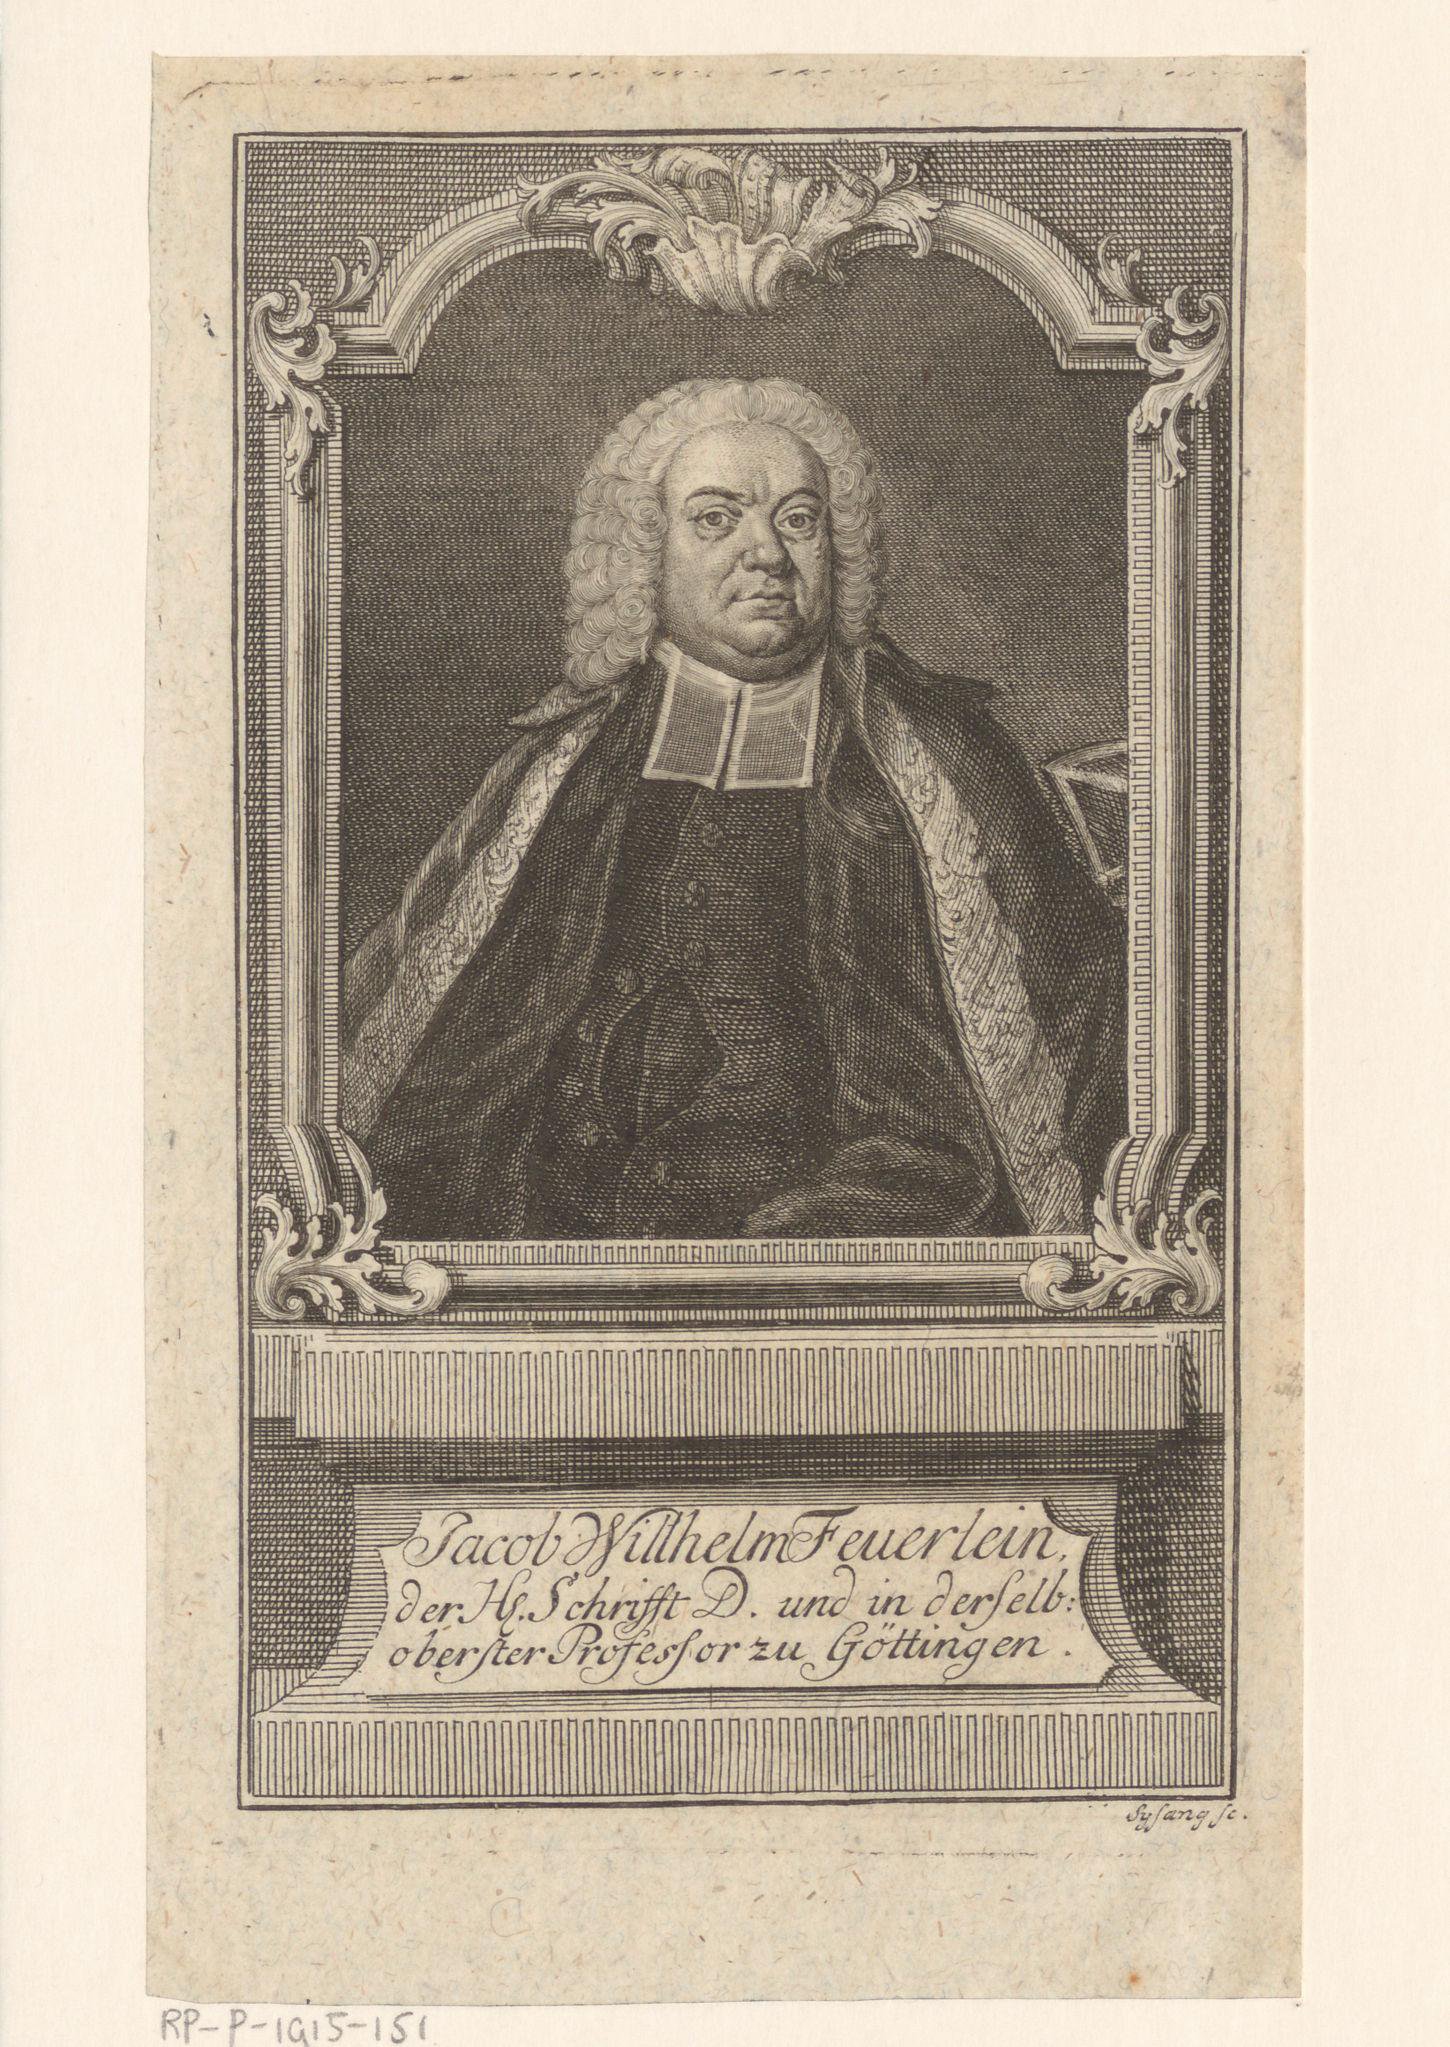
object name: print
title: Portret van Jacob Wilhelm Feuerlein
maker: johann christoph sysang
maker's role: print maker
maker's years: 1703-1757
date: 1737-1757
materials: paper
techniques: engraving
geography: leipzig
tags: historical persons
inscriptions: collector's mark: Lugt 2228